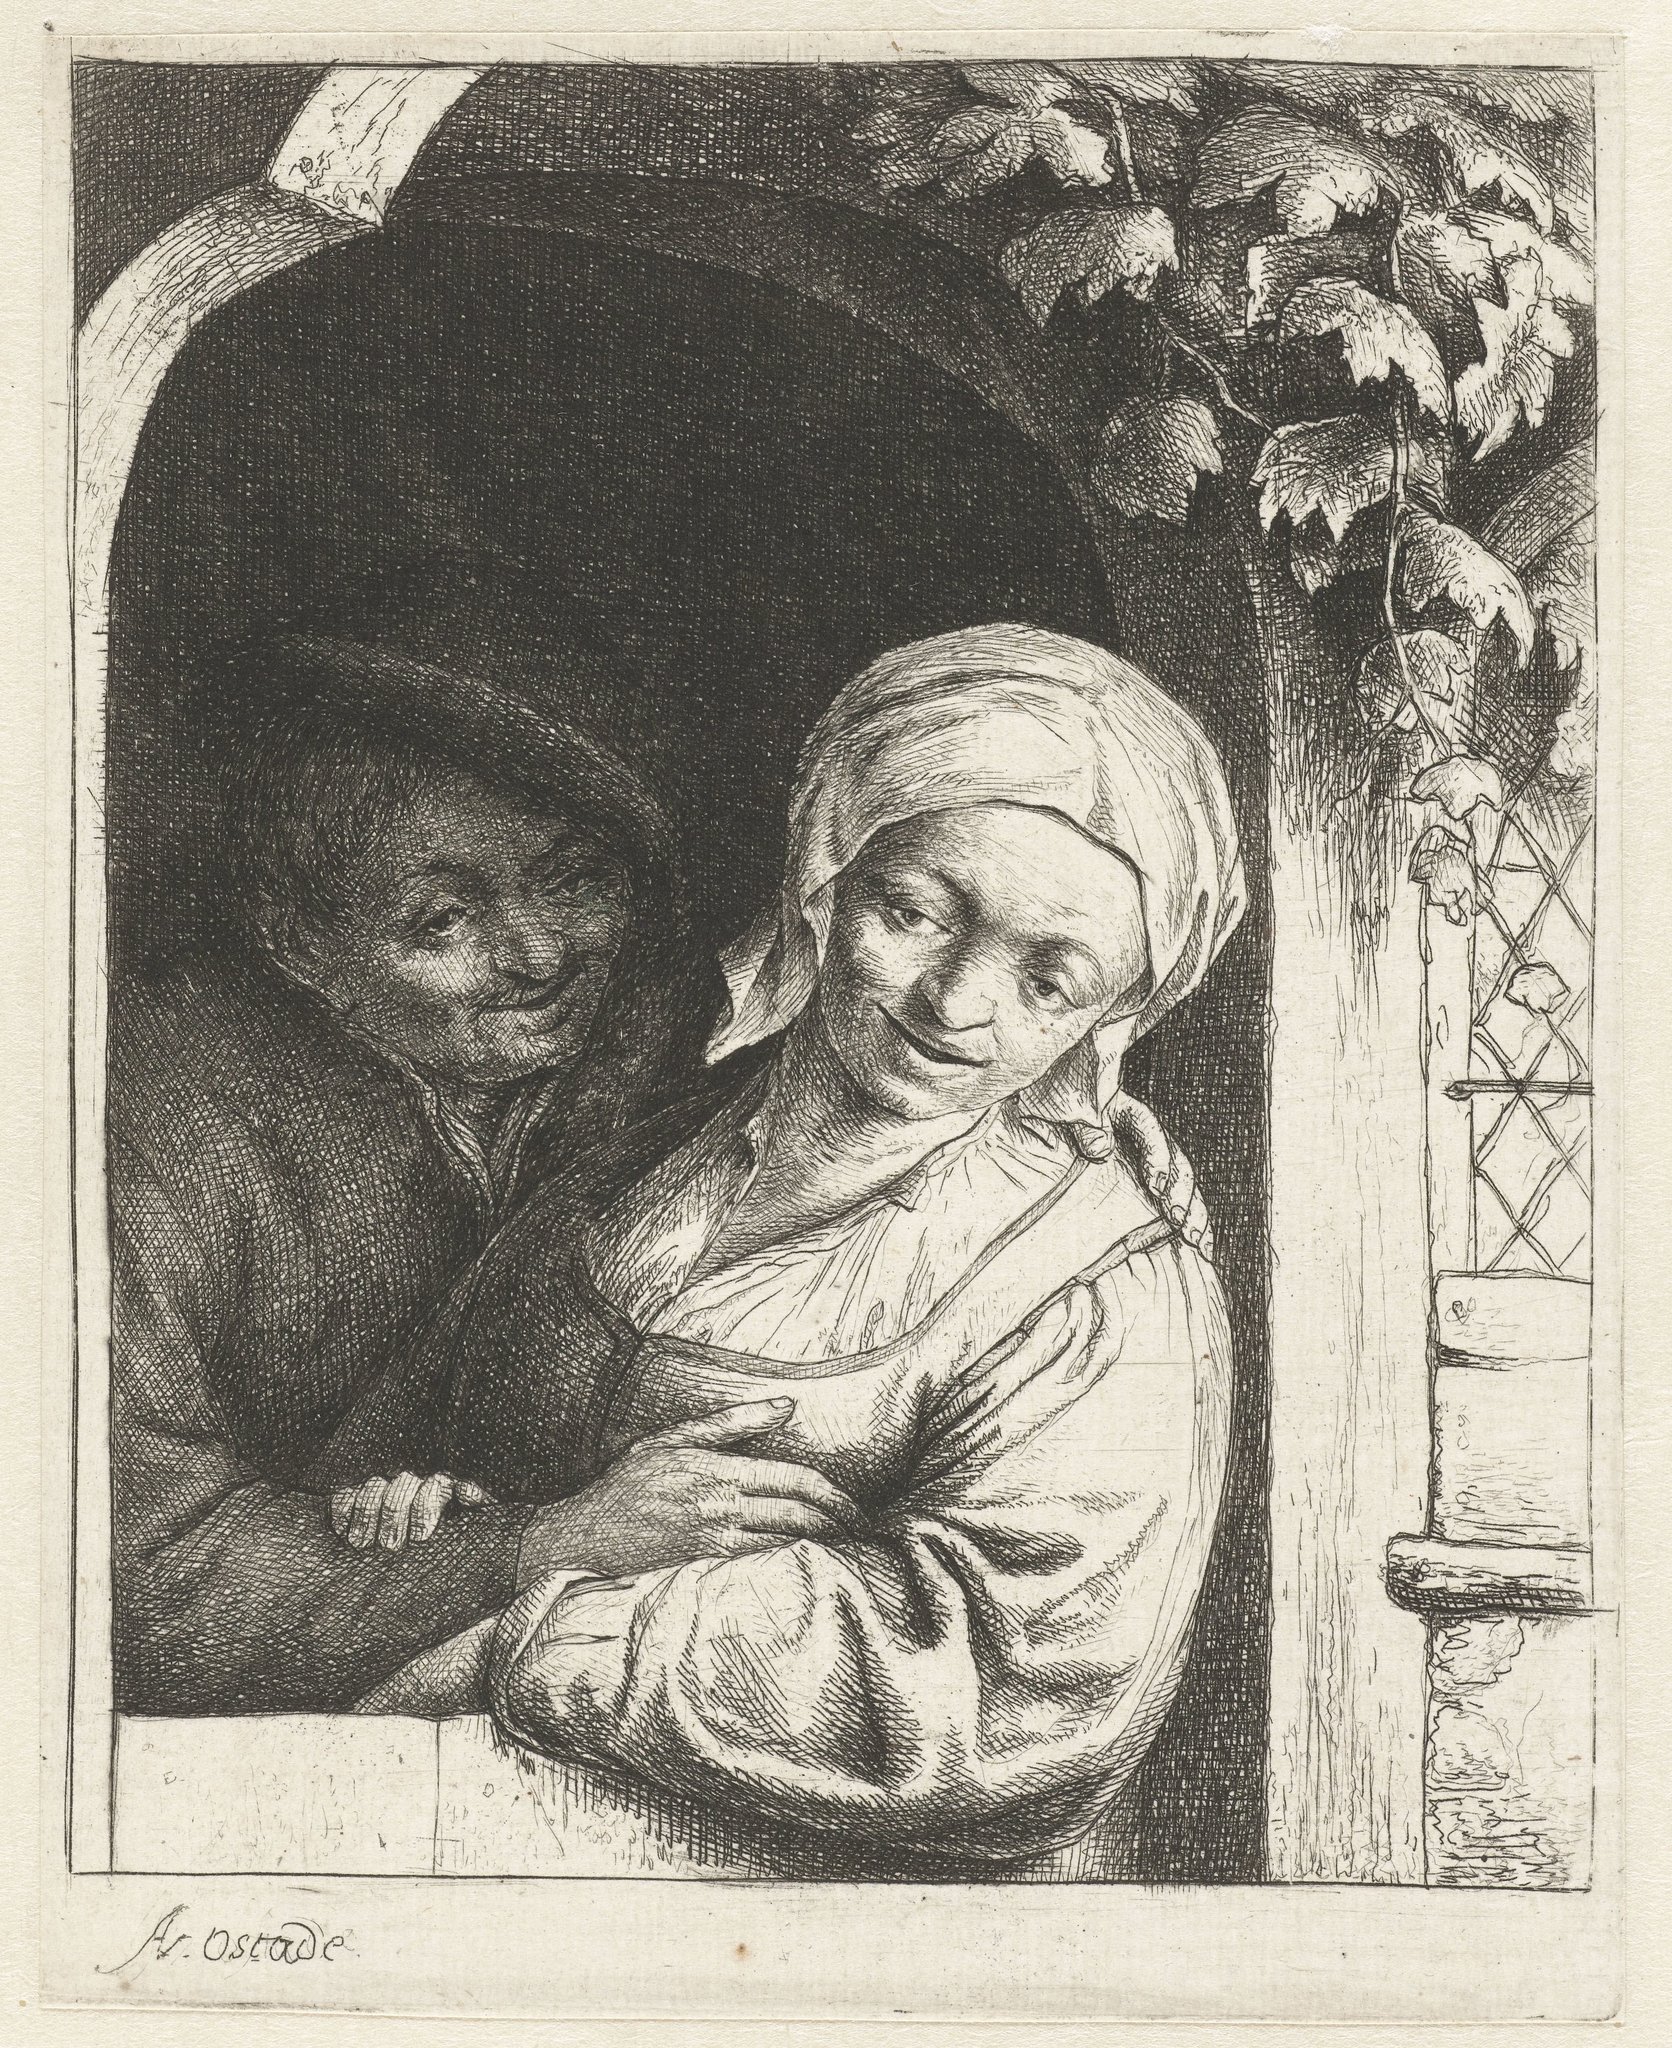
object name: print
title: Het boerenliefdespaar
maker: adriaen van ostade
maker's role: draughtsman, painter, print maker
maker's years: 1610-1685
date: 1650-1654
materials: paper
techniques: drypoint, etching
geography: haarlem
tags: couple of lovers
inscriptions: collector's mark: Lugt 240